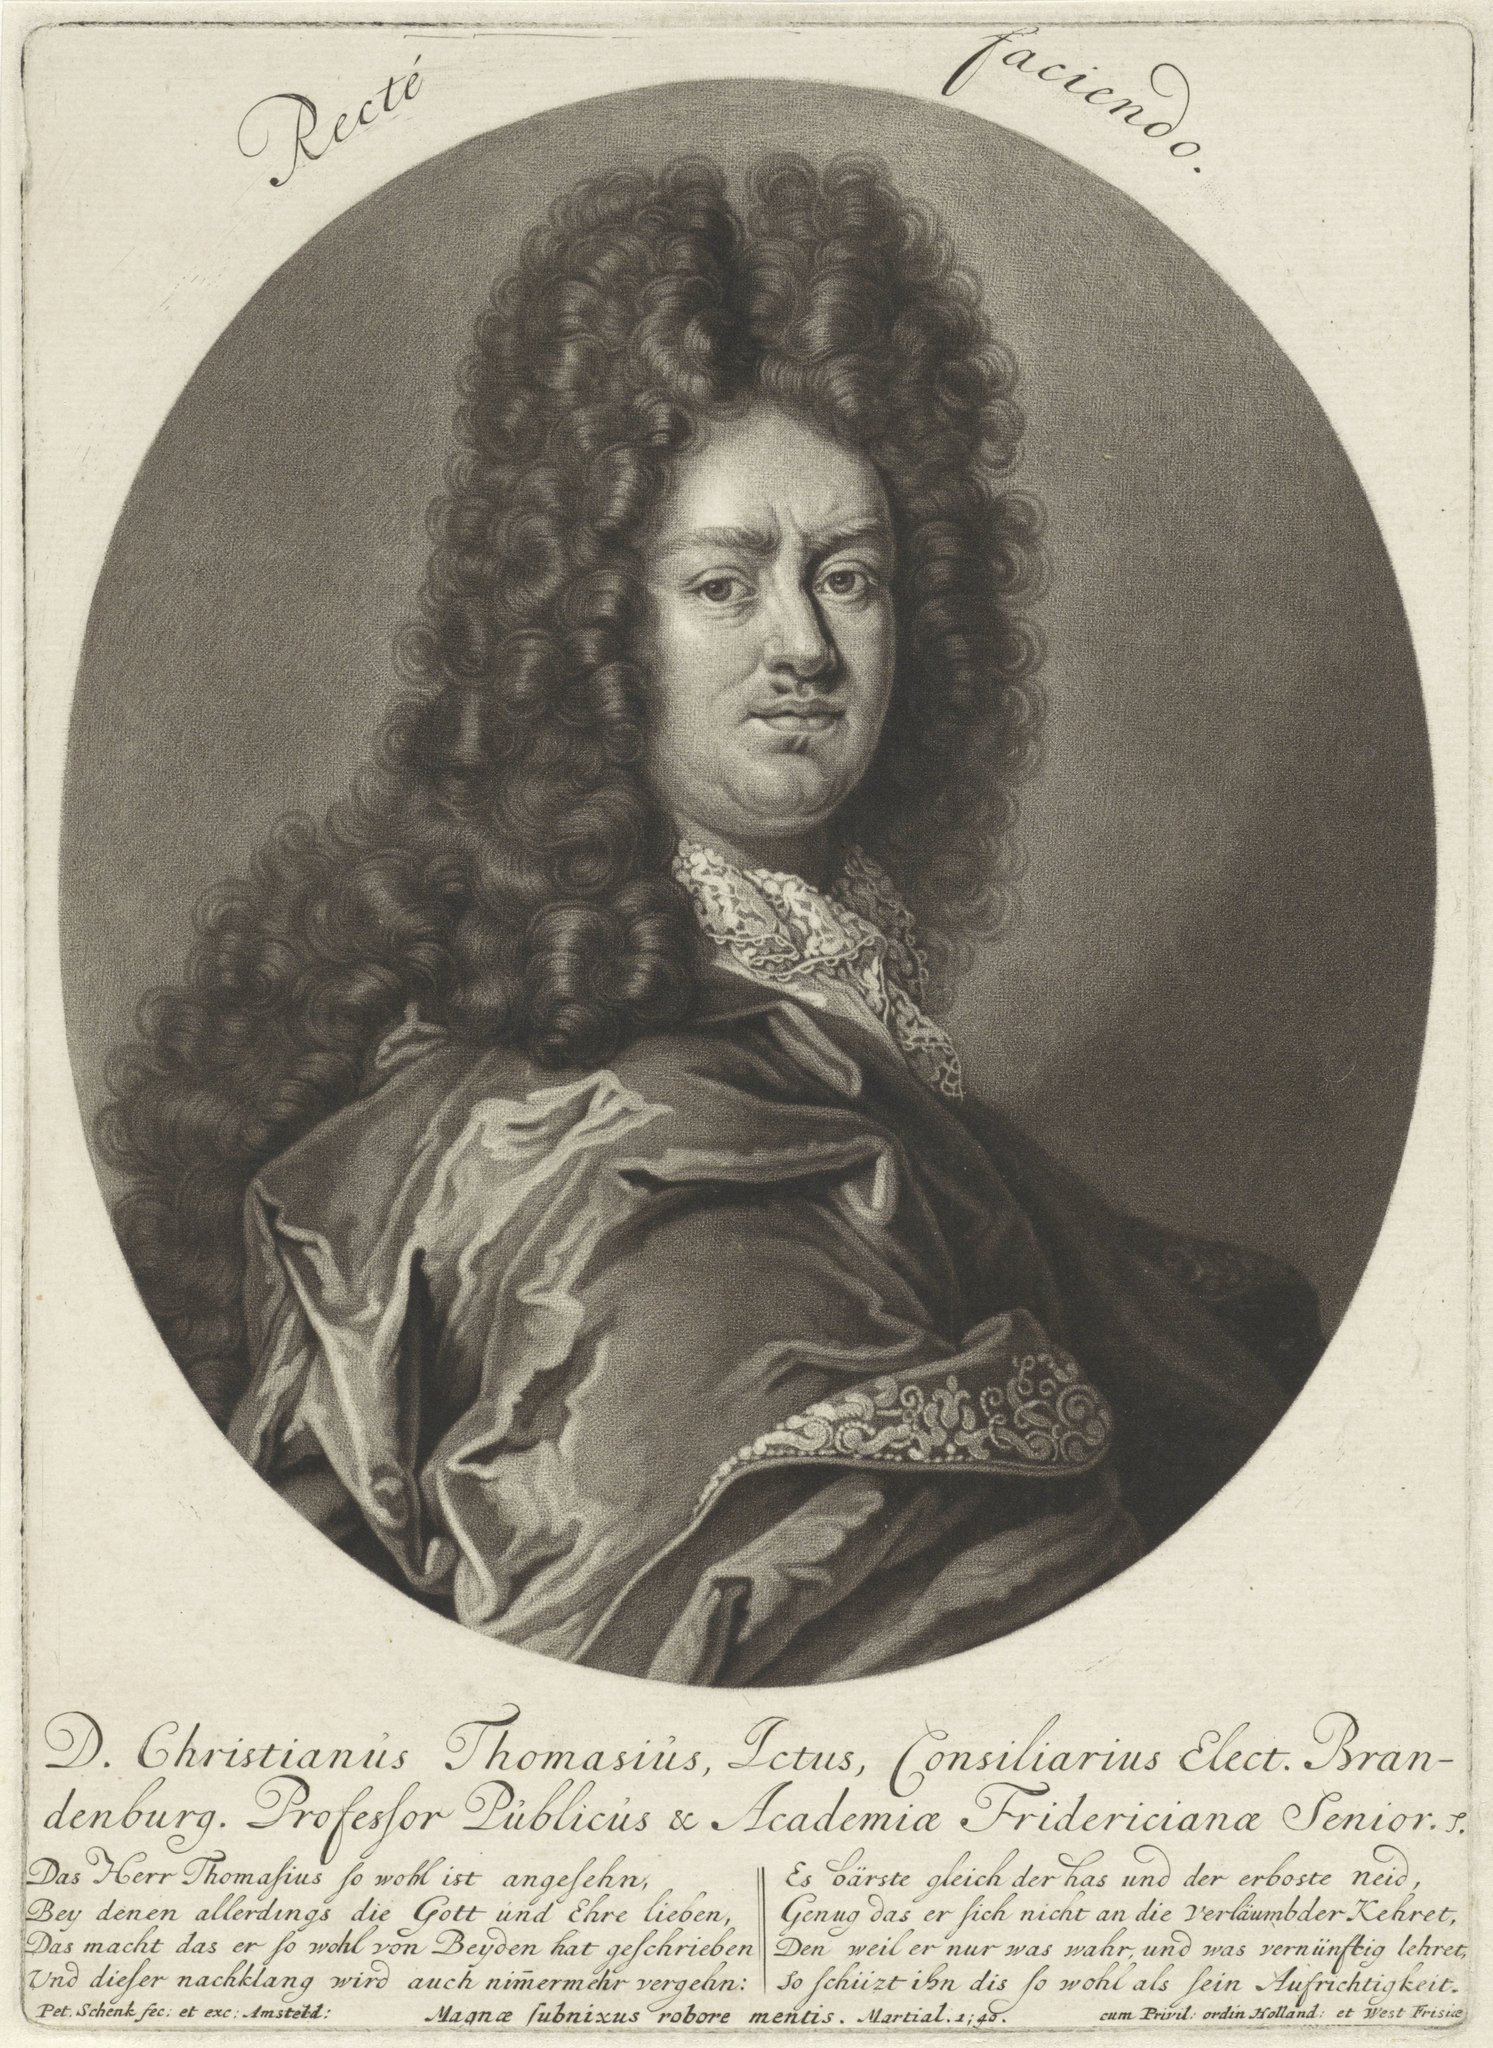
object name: print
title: Portret van de Duitse professor Christian Thomas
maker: pieter schenk (i)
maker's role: print maker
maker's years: 1660-1711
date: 1670-1713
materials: paper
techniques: engraving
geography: amsterdam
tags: wig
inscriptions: collector's mark: Lugt 2228